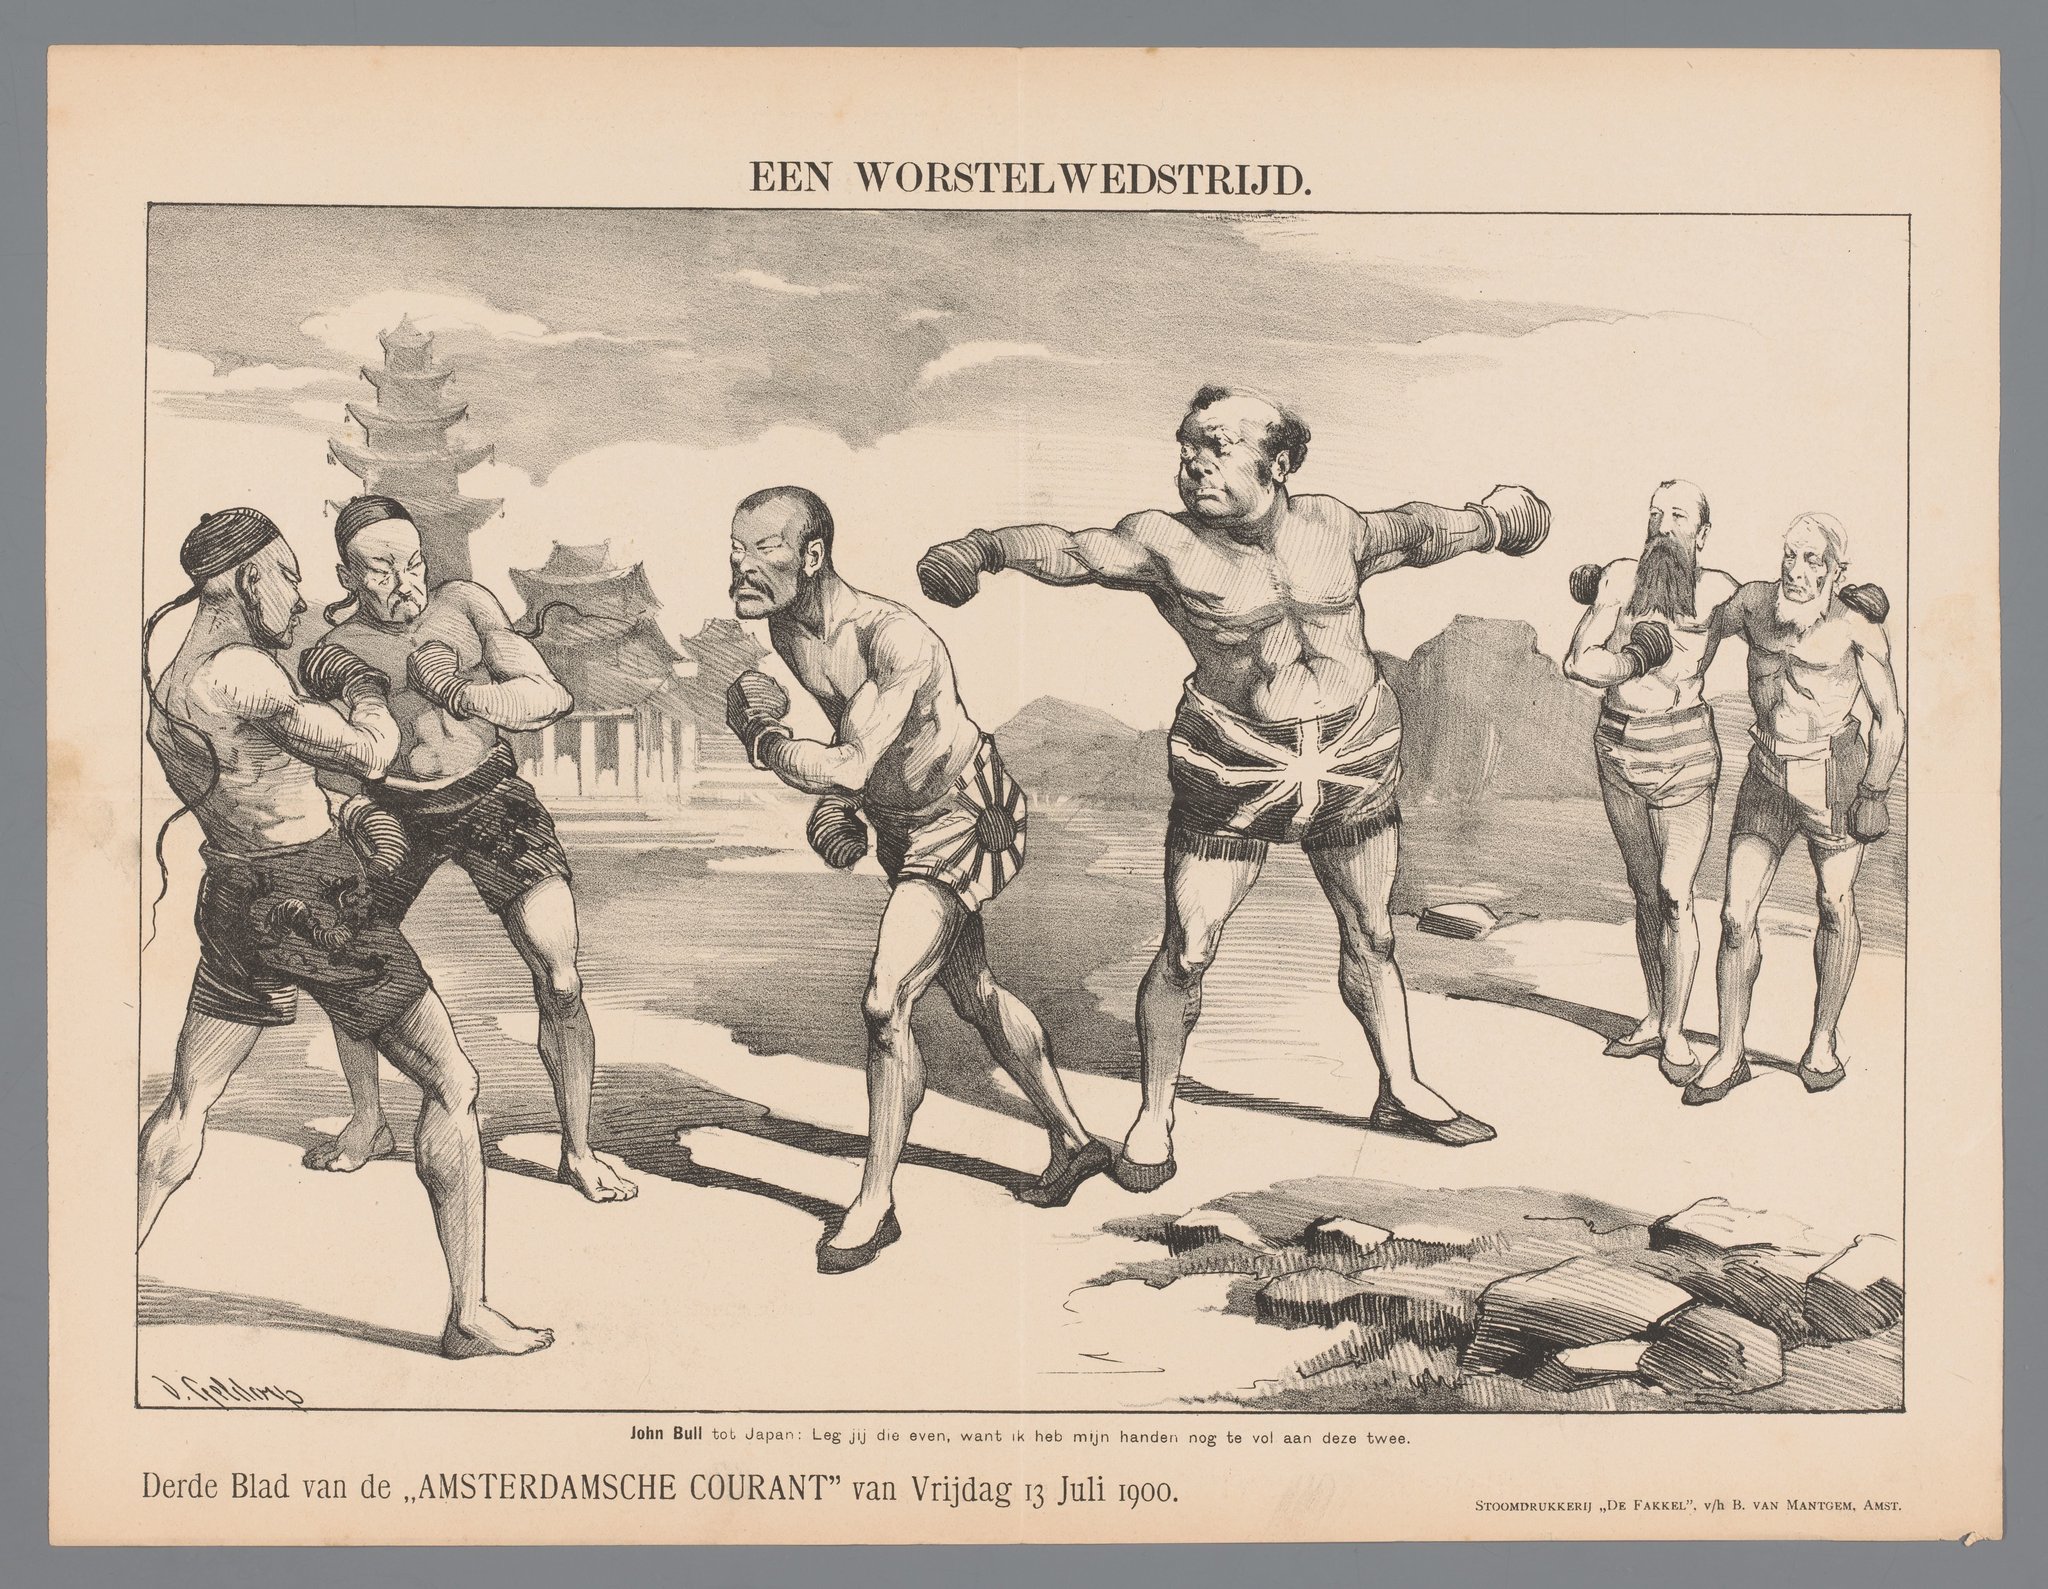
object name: cartoon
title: Een worstelwedstrijd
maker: petrus van geldorp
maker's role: draughtsman, print maker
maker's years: 1872-1939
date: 1900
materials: paper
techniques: lithograph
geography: amsterdam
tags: personifications of countries, nations, states, districts, etc., wrestling (sport), politician, e.g. party leader, political caricatures and satires, united kingdom, china, japan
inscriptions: date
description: Prent uit het bijvoegsel van: De Amsterdamsche Courant, 13 juli 1900.